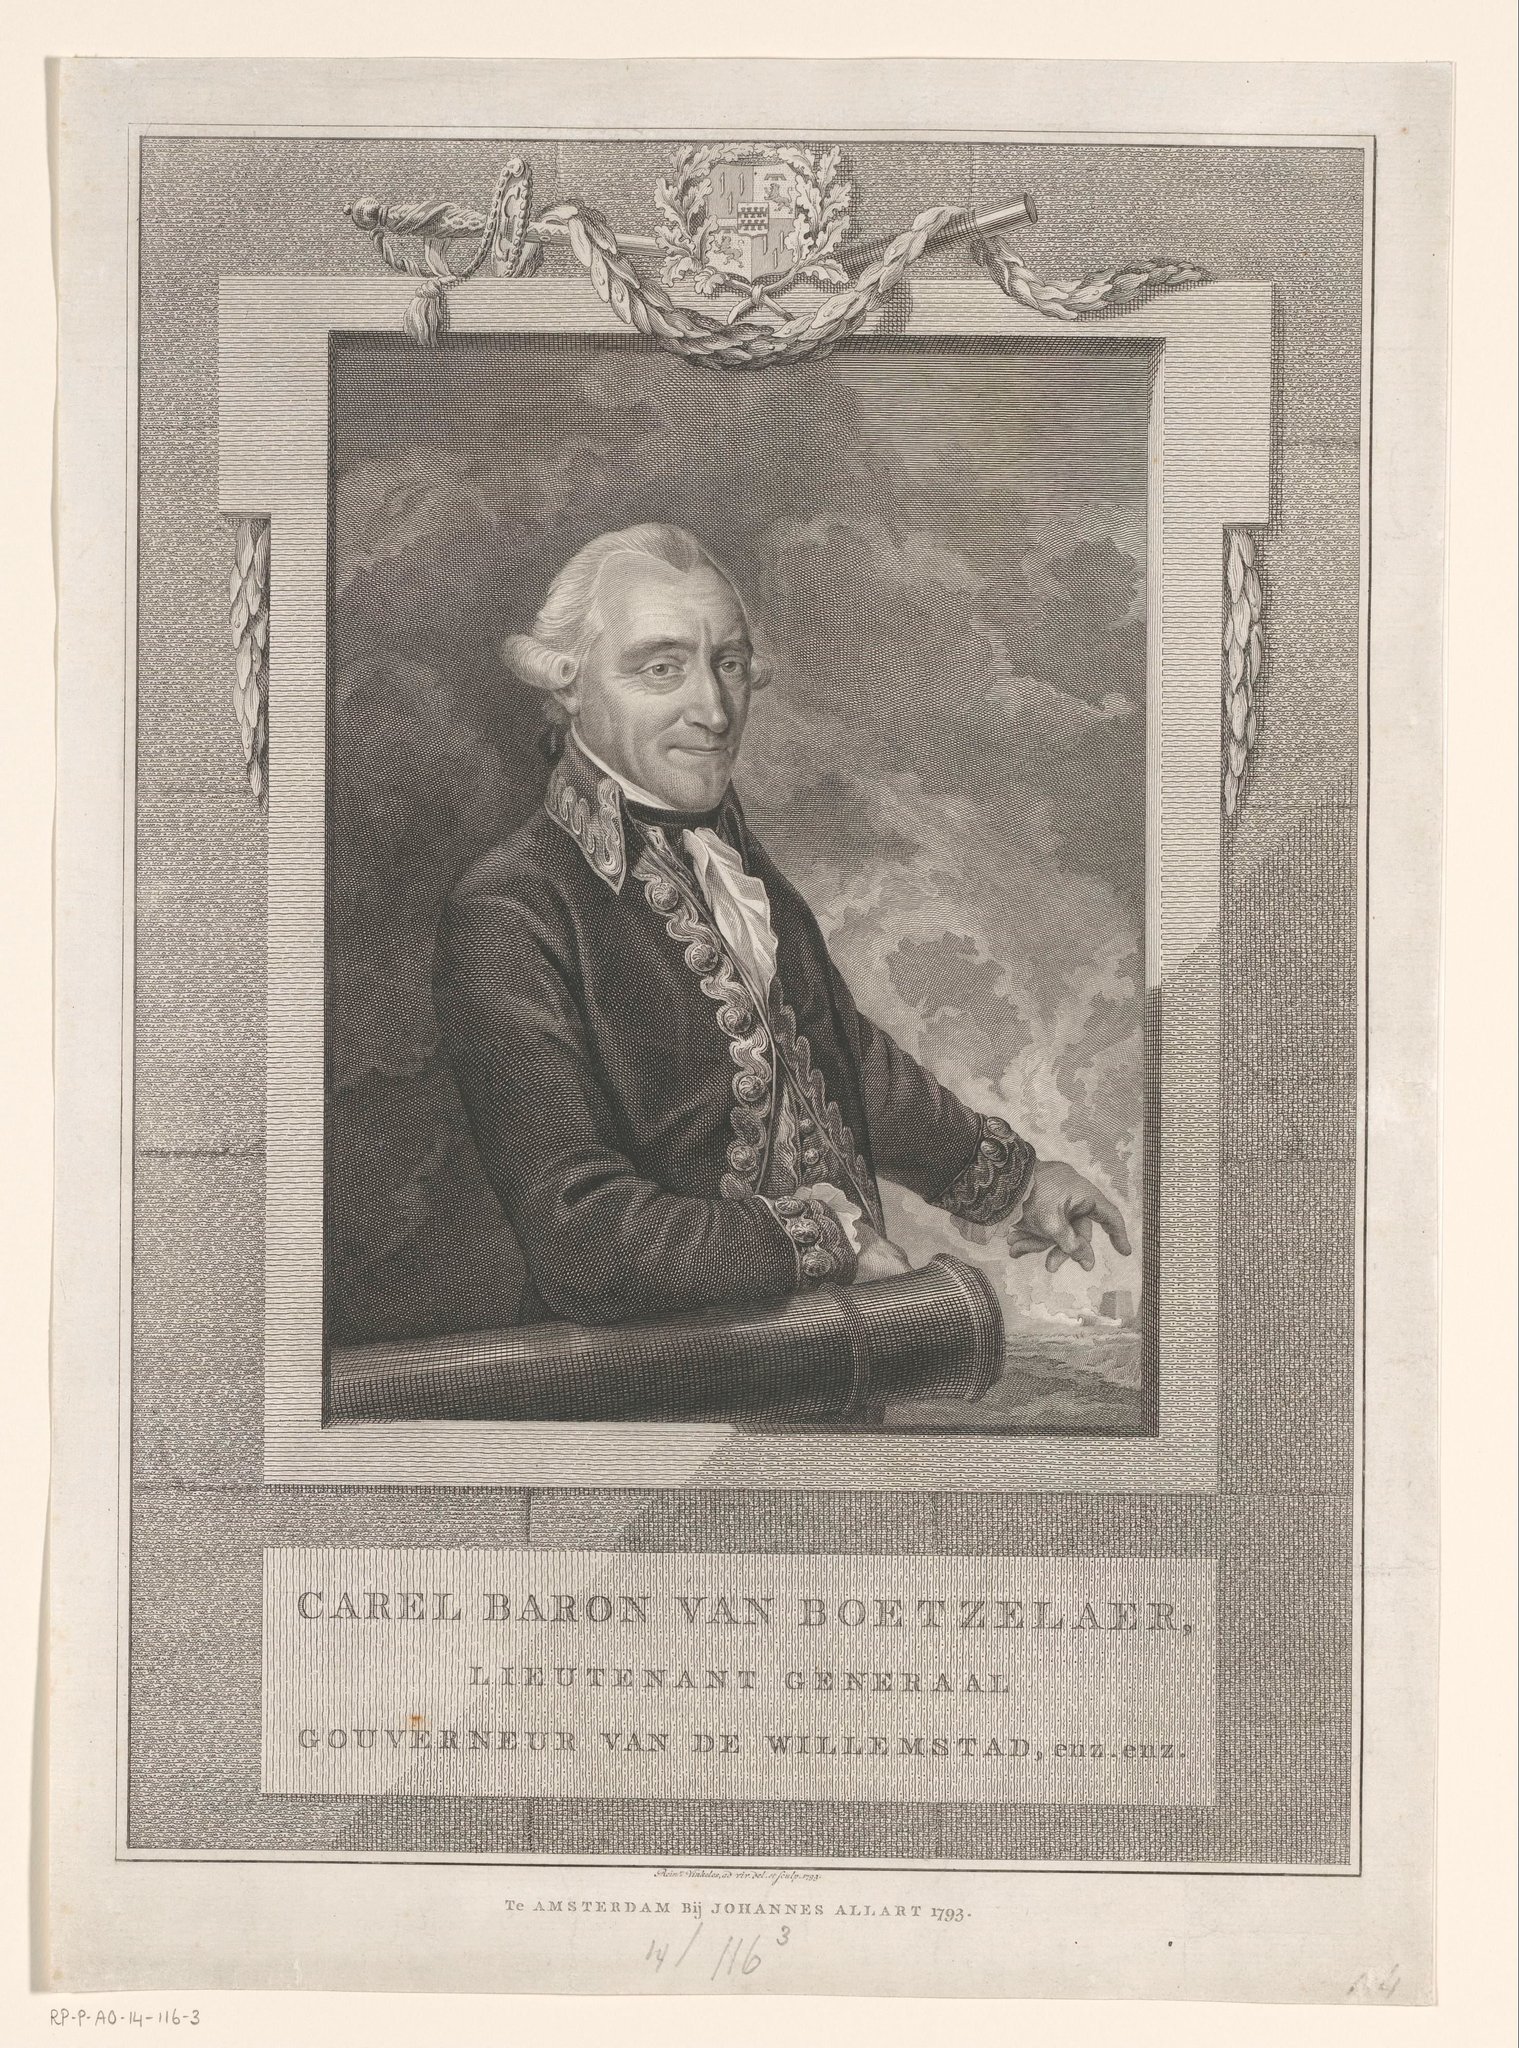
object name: print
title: Portret van Carel baron van Boetzelaer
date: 1793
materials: paper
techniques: engraving, etching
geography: amsterdam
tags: historical persons, firearms: cannon, armorial bearing, heraldry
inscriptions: date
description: Portret van Carel baron van Boetzelaer, luitenant-generaal en gouverneur van Willemstad. Onder het portret zijn naam en gegevens in drie regels in het Nederlands.